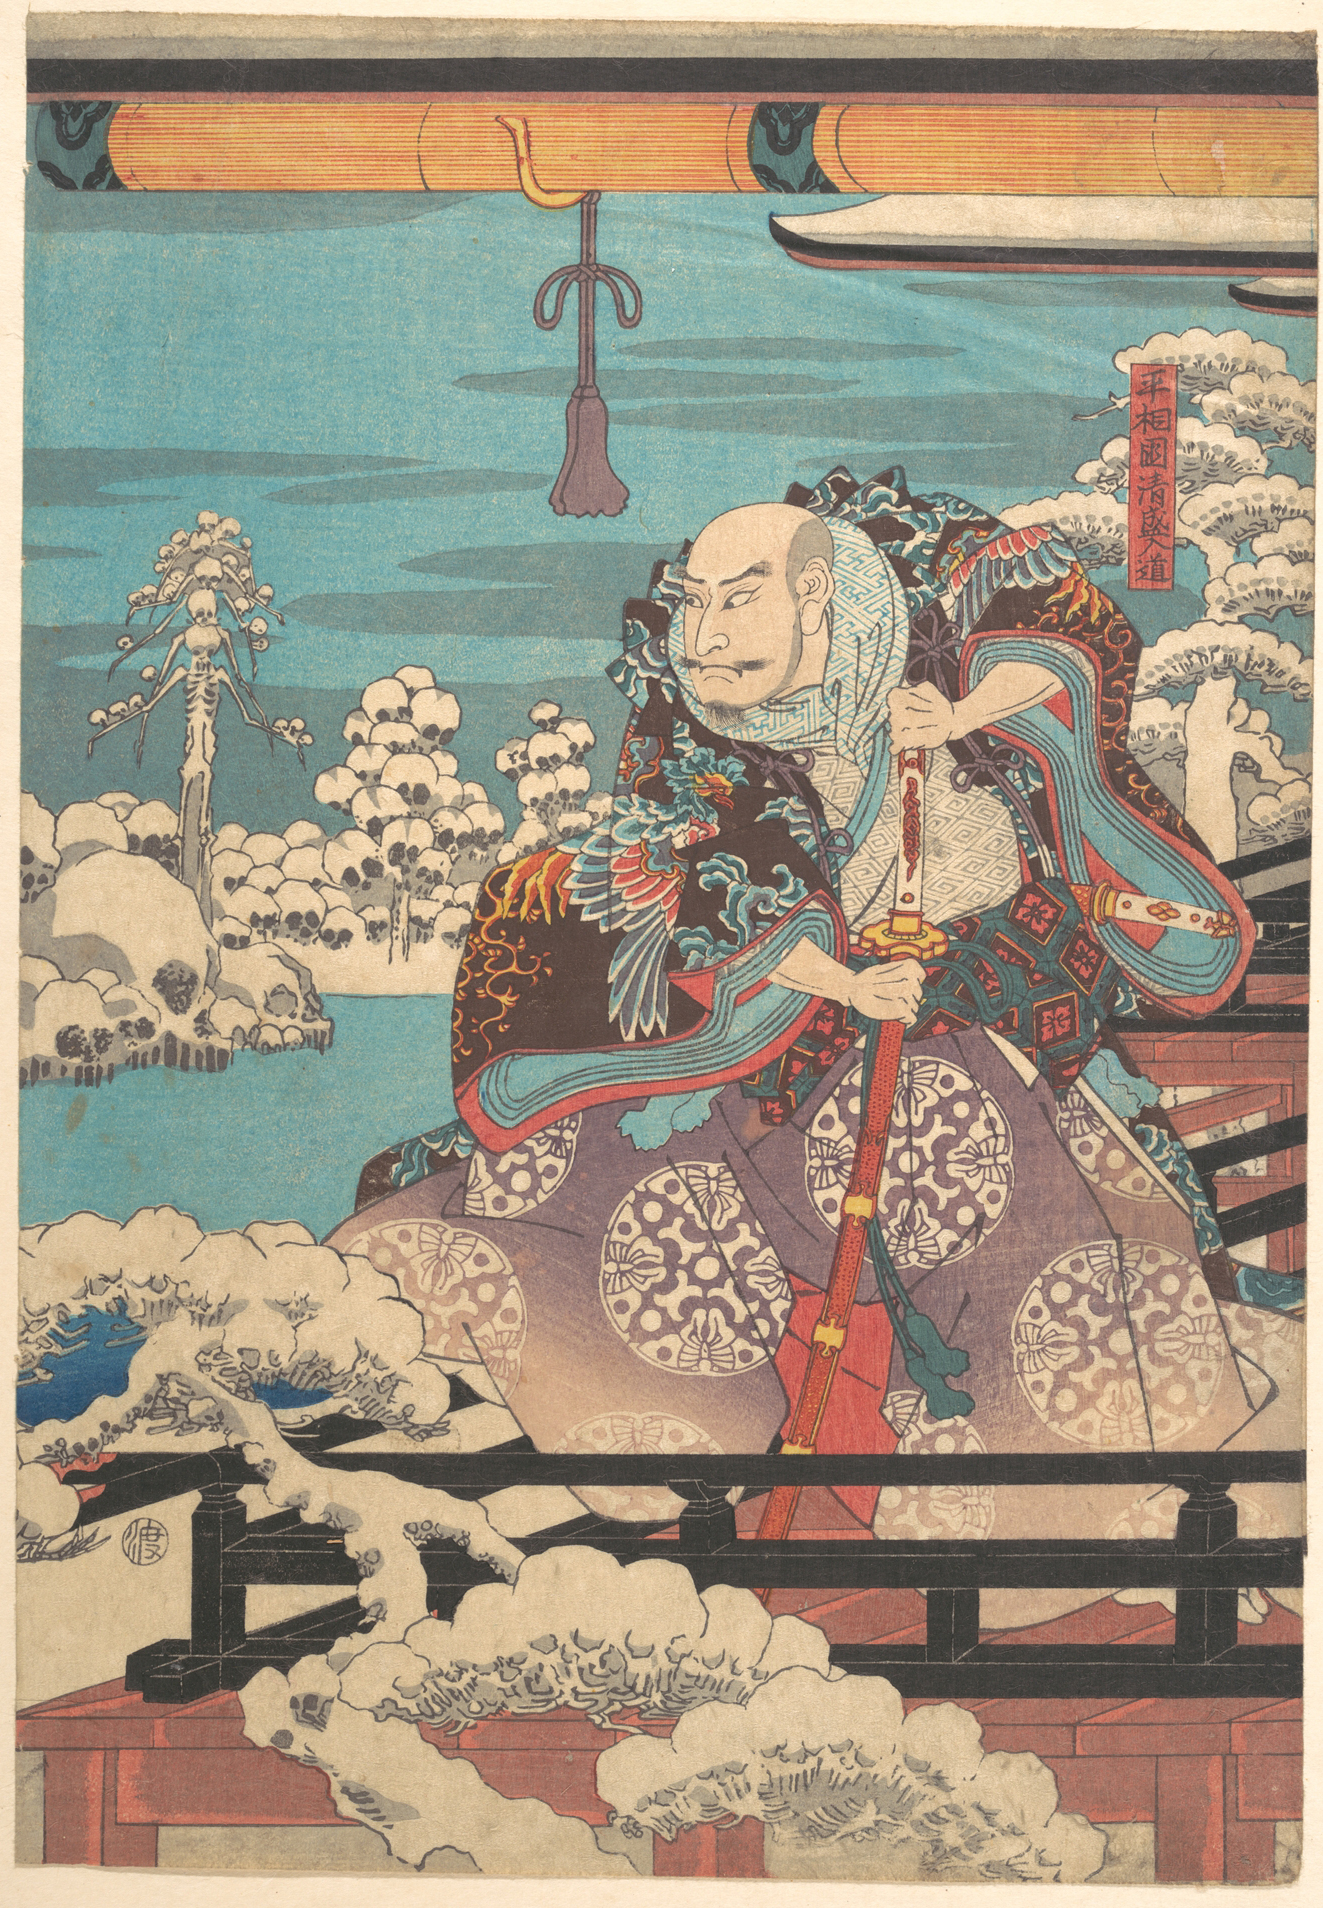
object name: print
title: (Untitled)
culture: japanese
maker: utagawa hiroshige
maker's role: artist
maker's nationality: japanese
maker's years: 1797-1858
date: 1797-1858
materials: ink, paper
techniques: woodblock print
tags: swords,skeletons,skulls,men